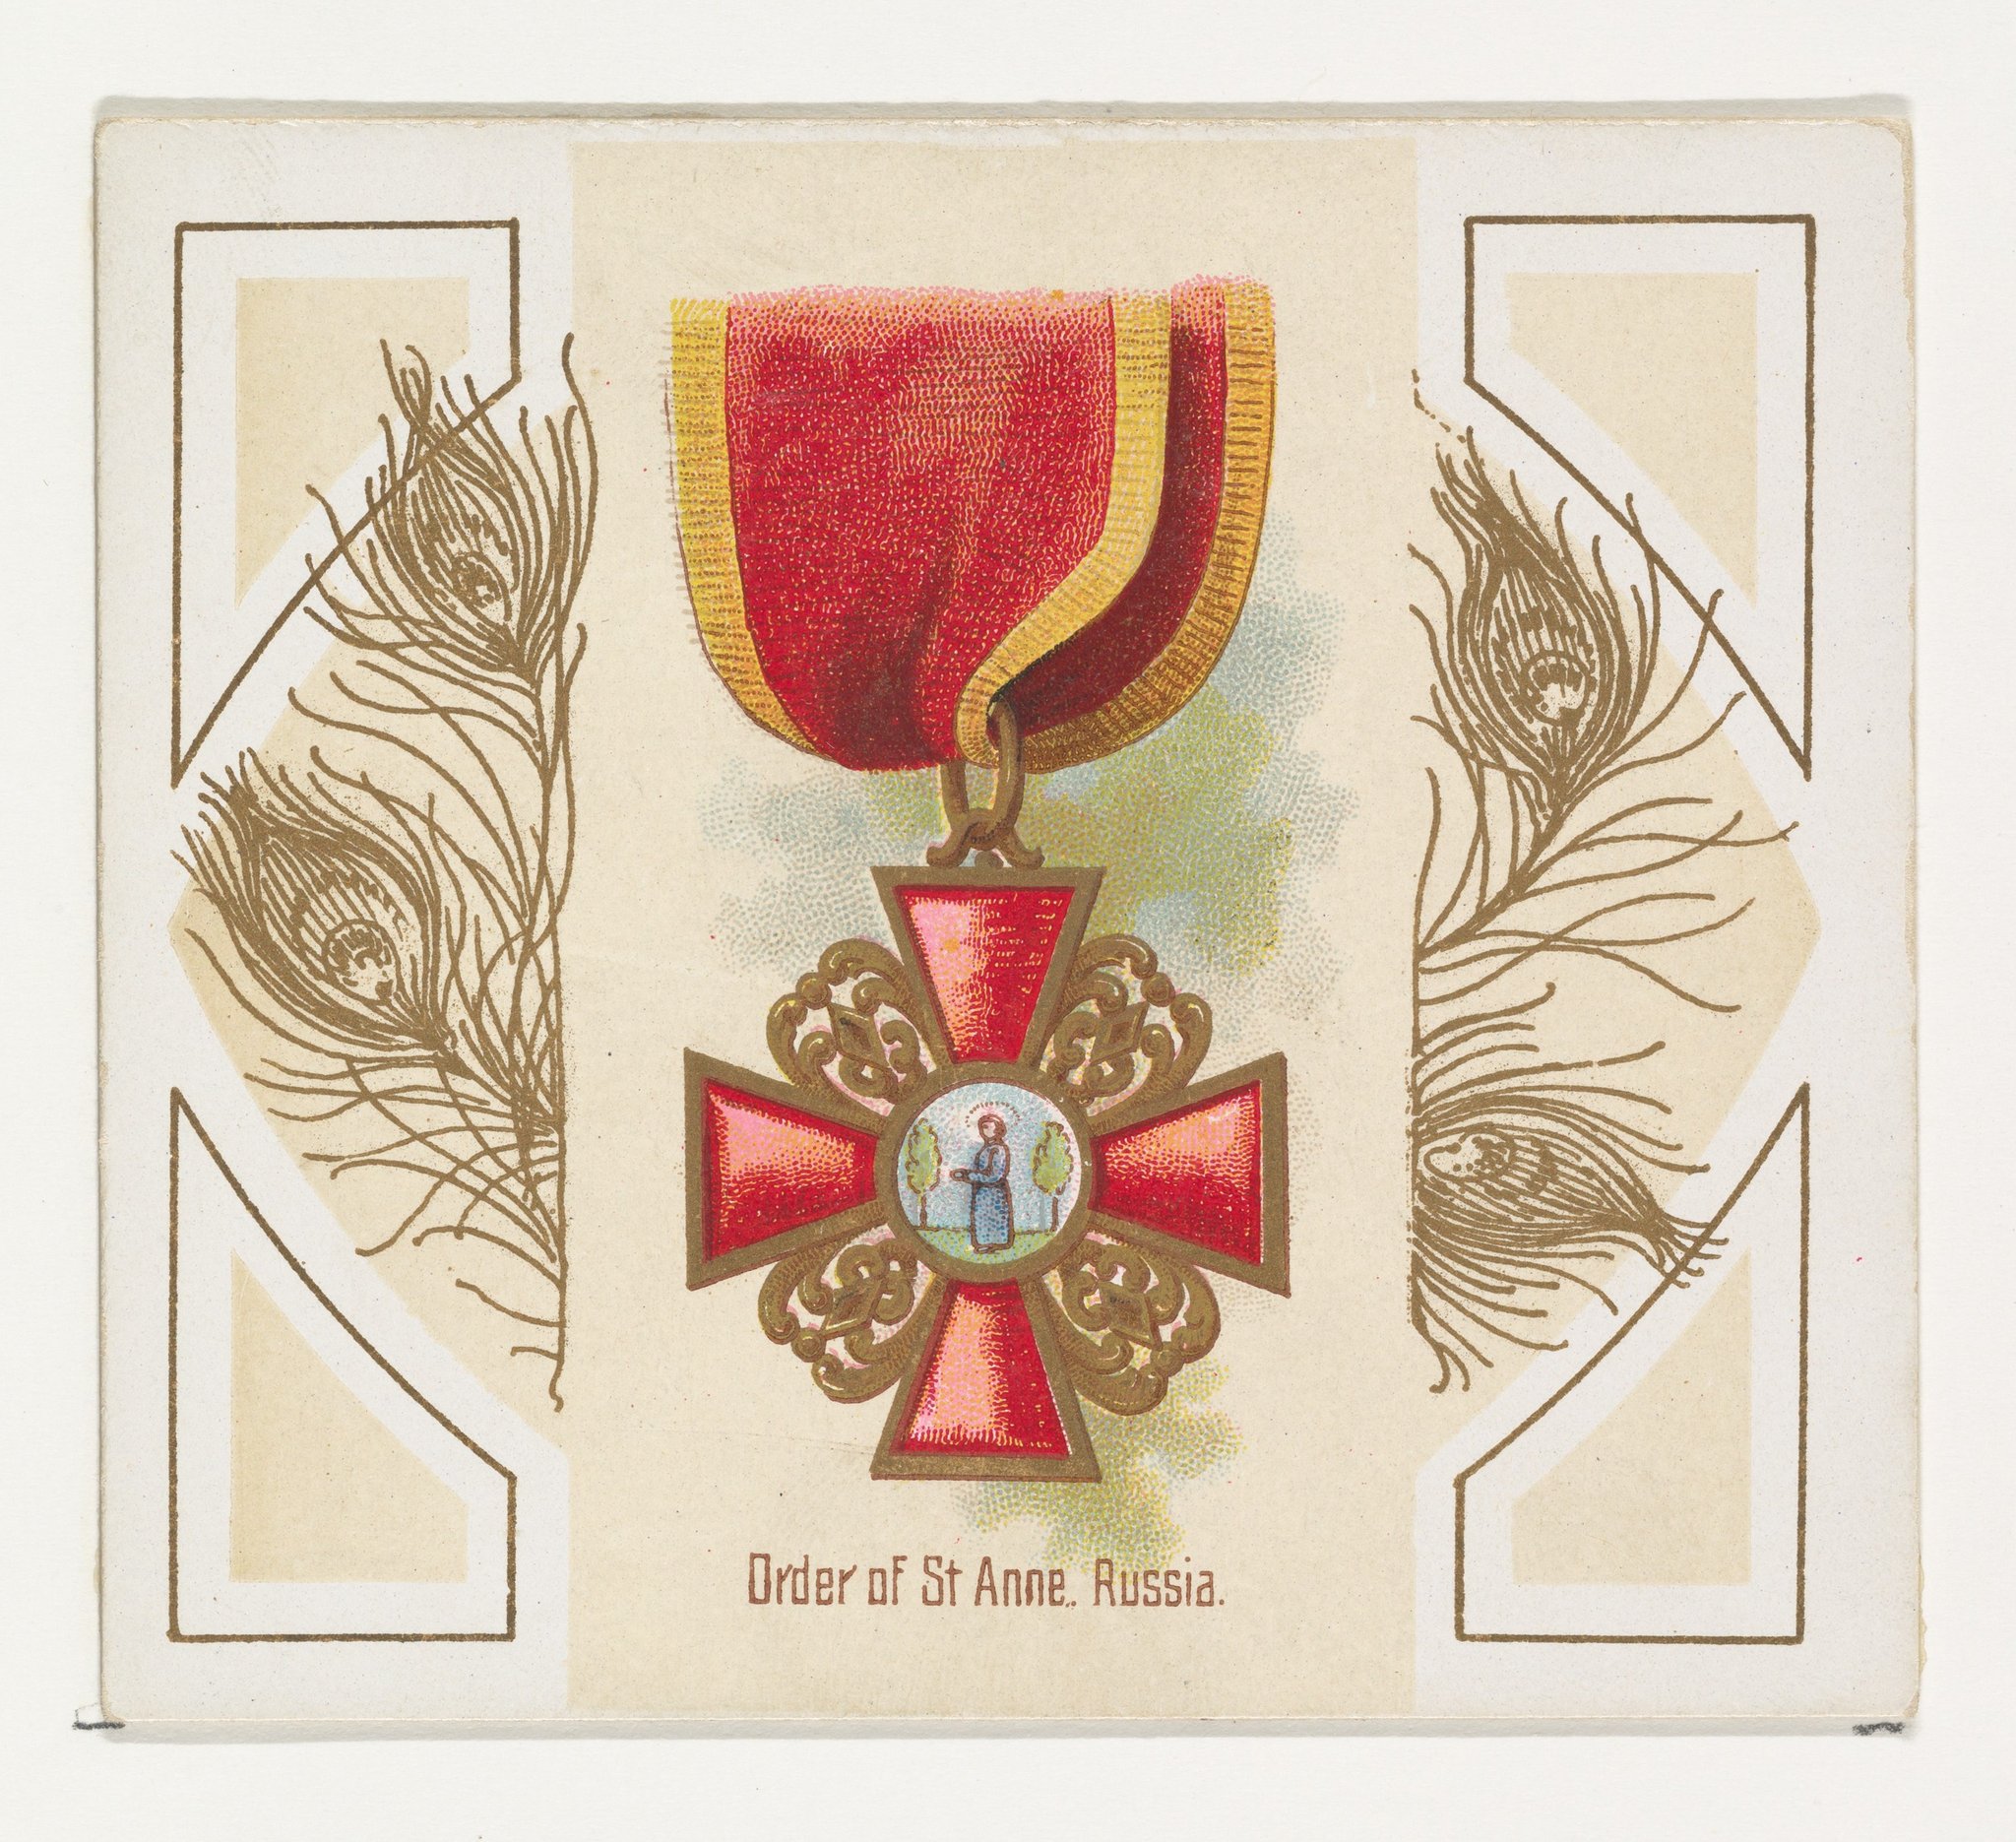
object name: print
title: Order of Saint Anne, Russia, from the World's Decorations series (N44) for Allen & Ginter Cigarettes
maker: allen & ginter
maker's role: publisher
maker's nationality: american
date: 1890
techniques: color lithograph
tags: medals